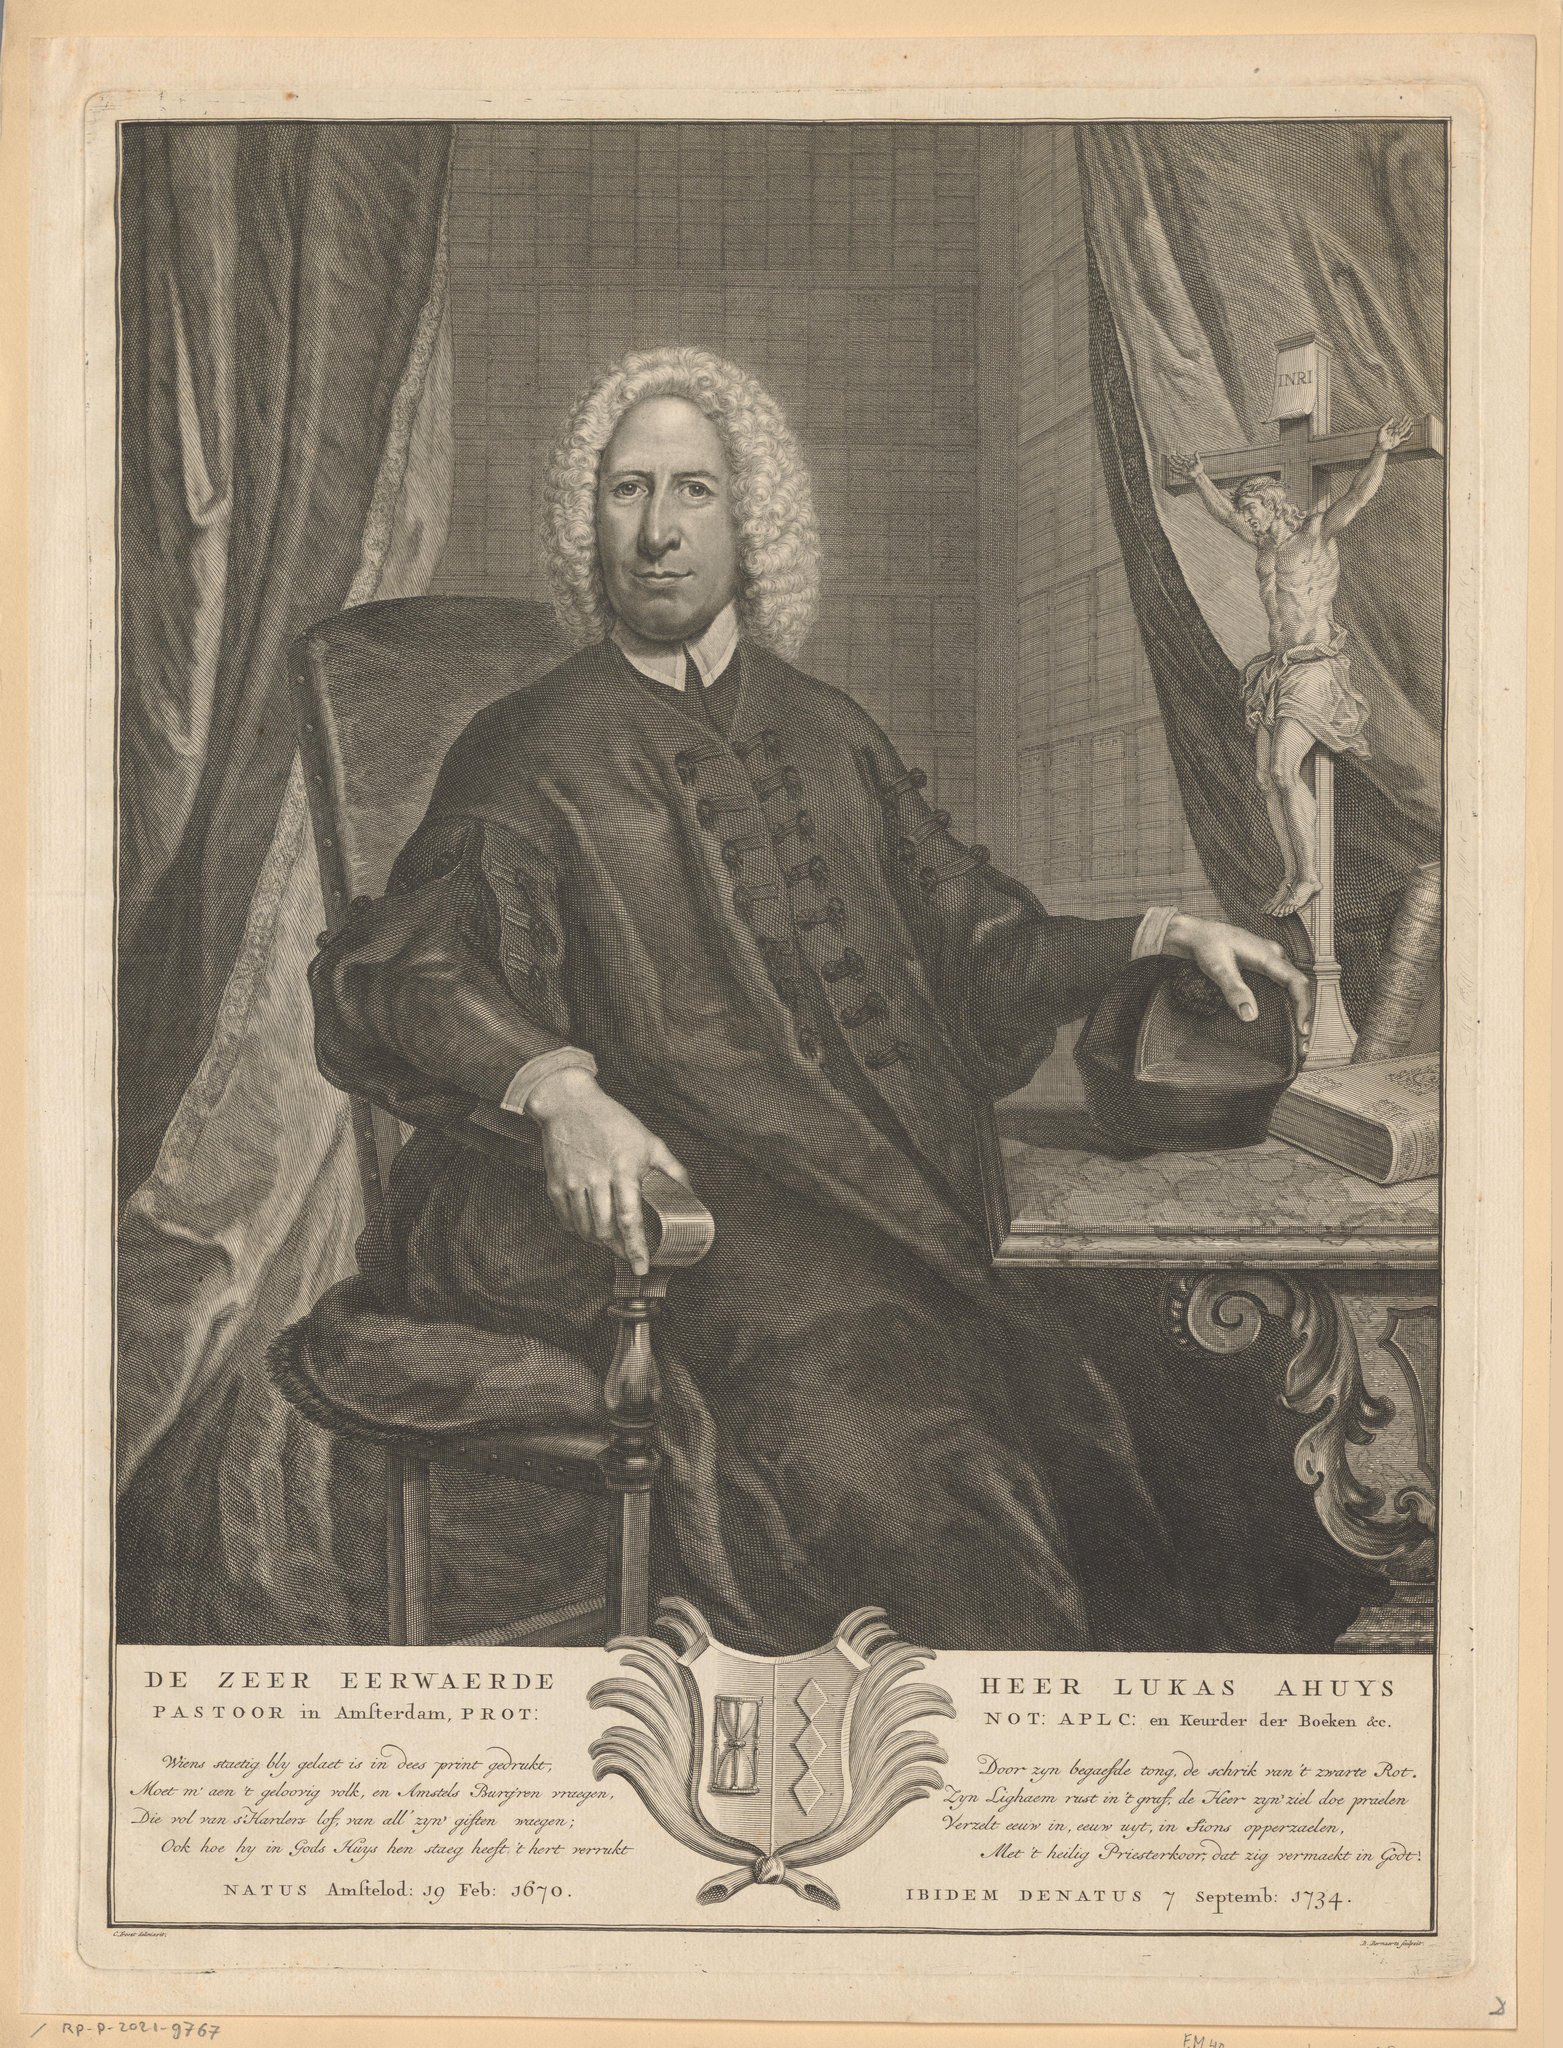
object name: print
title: De zeer eerwaerde heer Lukas Ahuys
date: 1734-1737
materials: paper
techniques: engraving, etching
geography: amsterdam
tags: bookshelves, historical persons, functionaries and dignitaries ~ episcopal protestant churches, book, crucifix ~ personal devotion, armorial bearing, heraldry